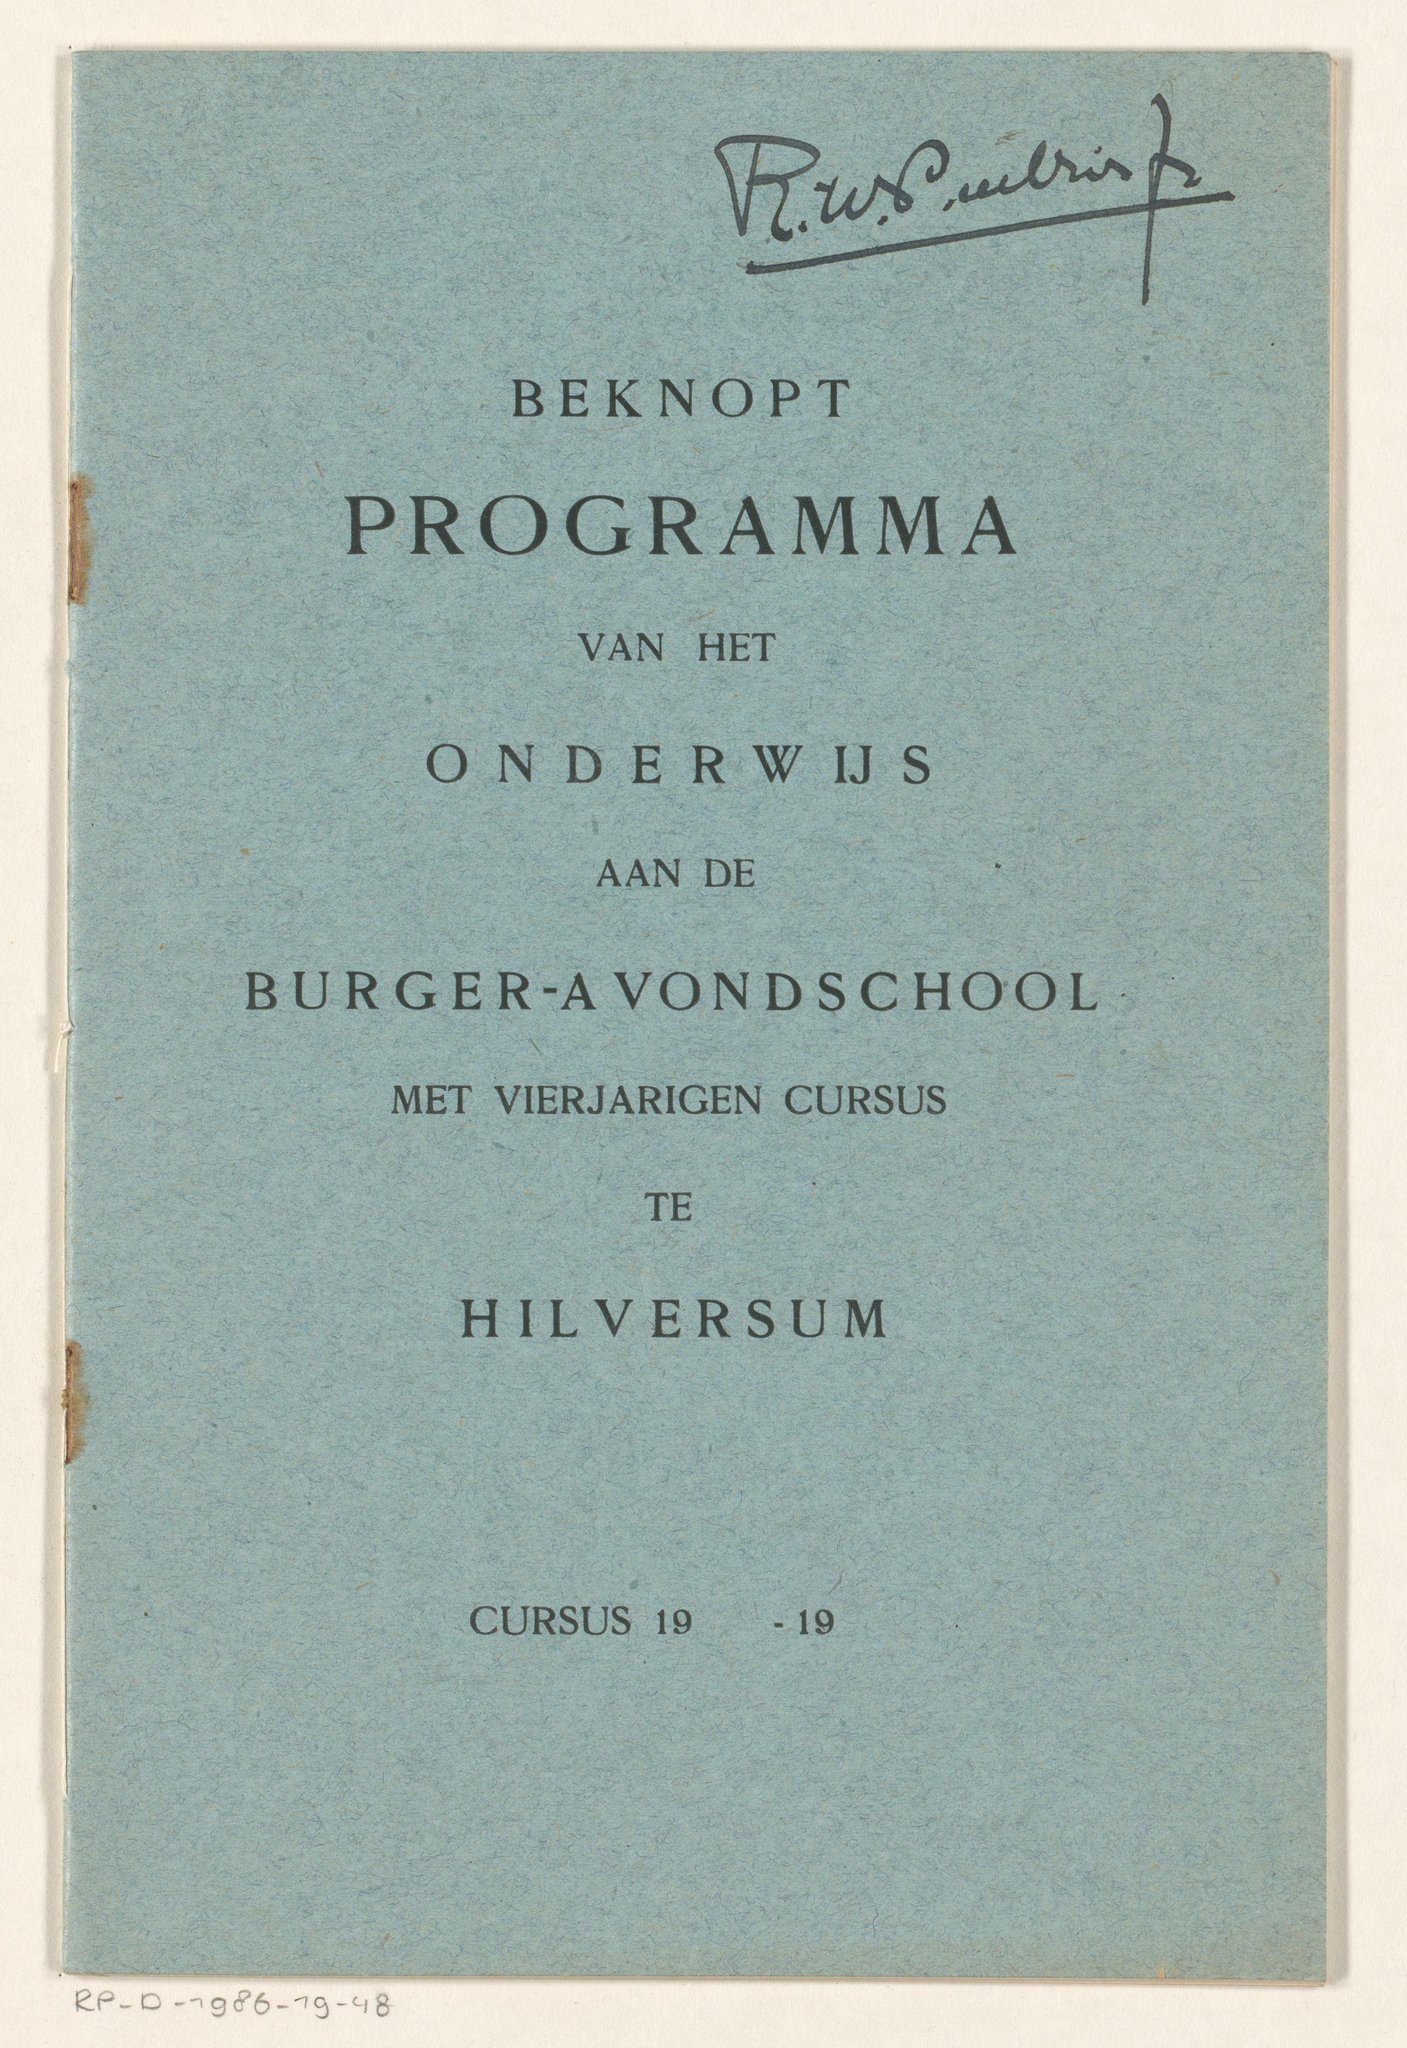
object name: brochure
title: Onderwijsprogramma van de burgeravondschool te Hilversum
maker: Anonymous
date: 1919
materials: paper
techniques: printing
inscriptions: collector's mark: ‘R:MVS.’, name: ‘R.W.P. deVries Jr’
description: Exemplaar van R.W.P. de Vries Jr., die zijn naam op de omslag heeft genoteerd.